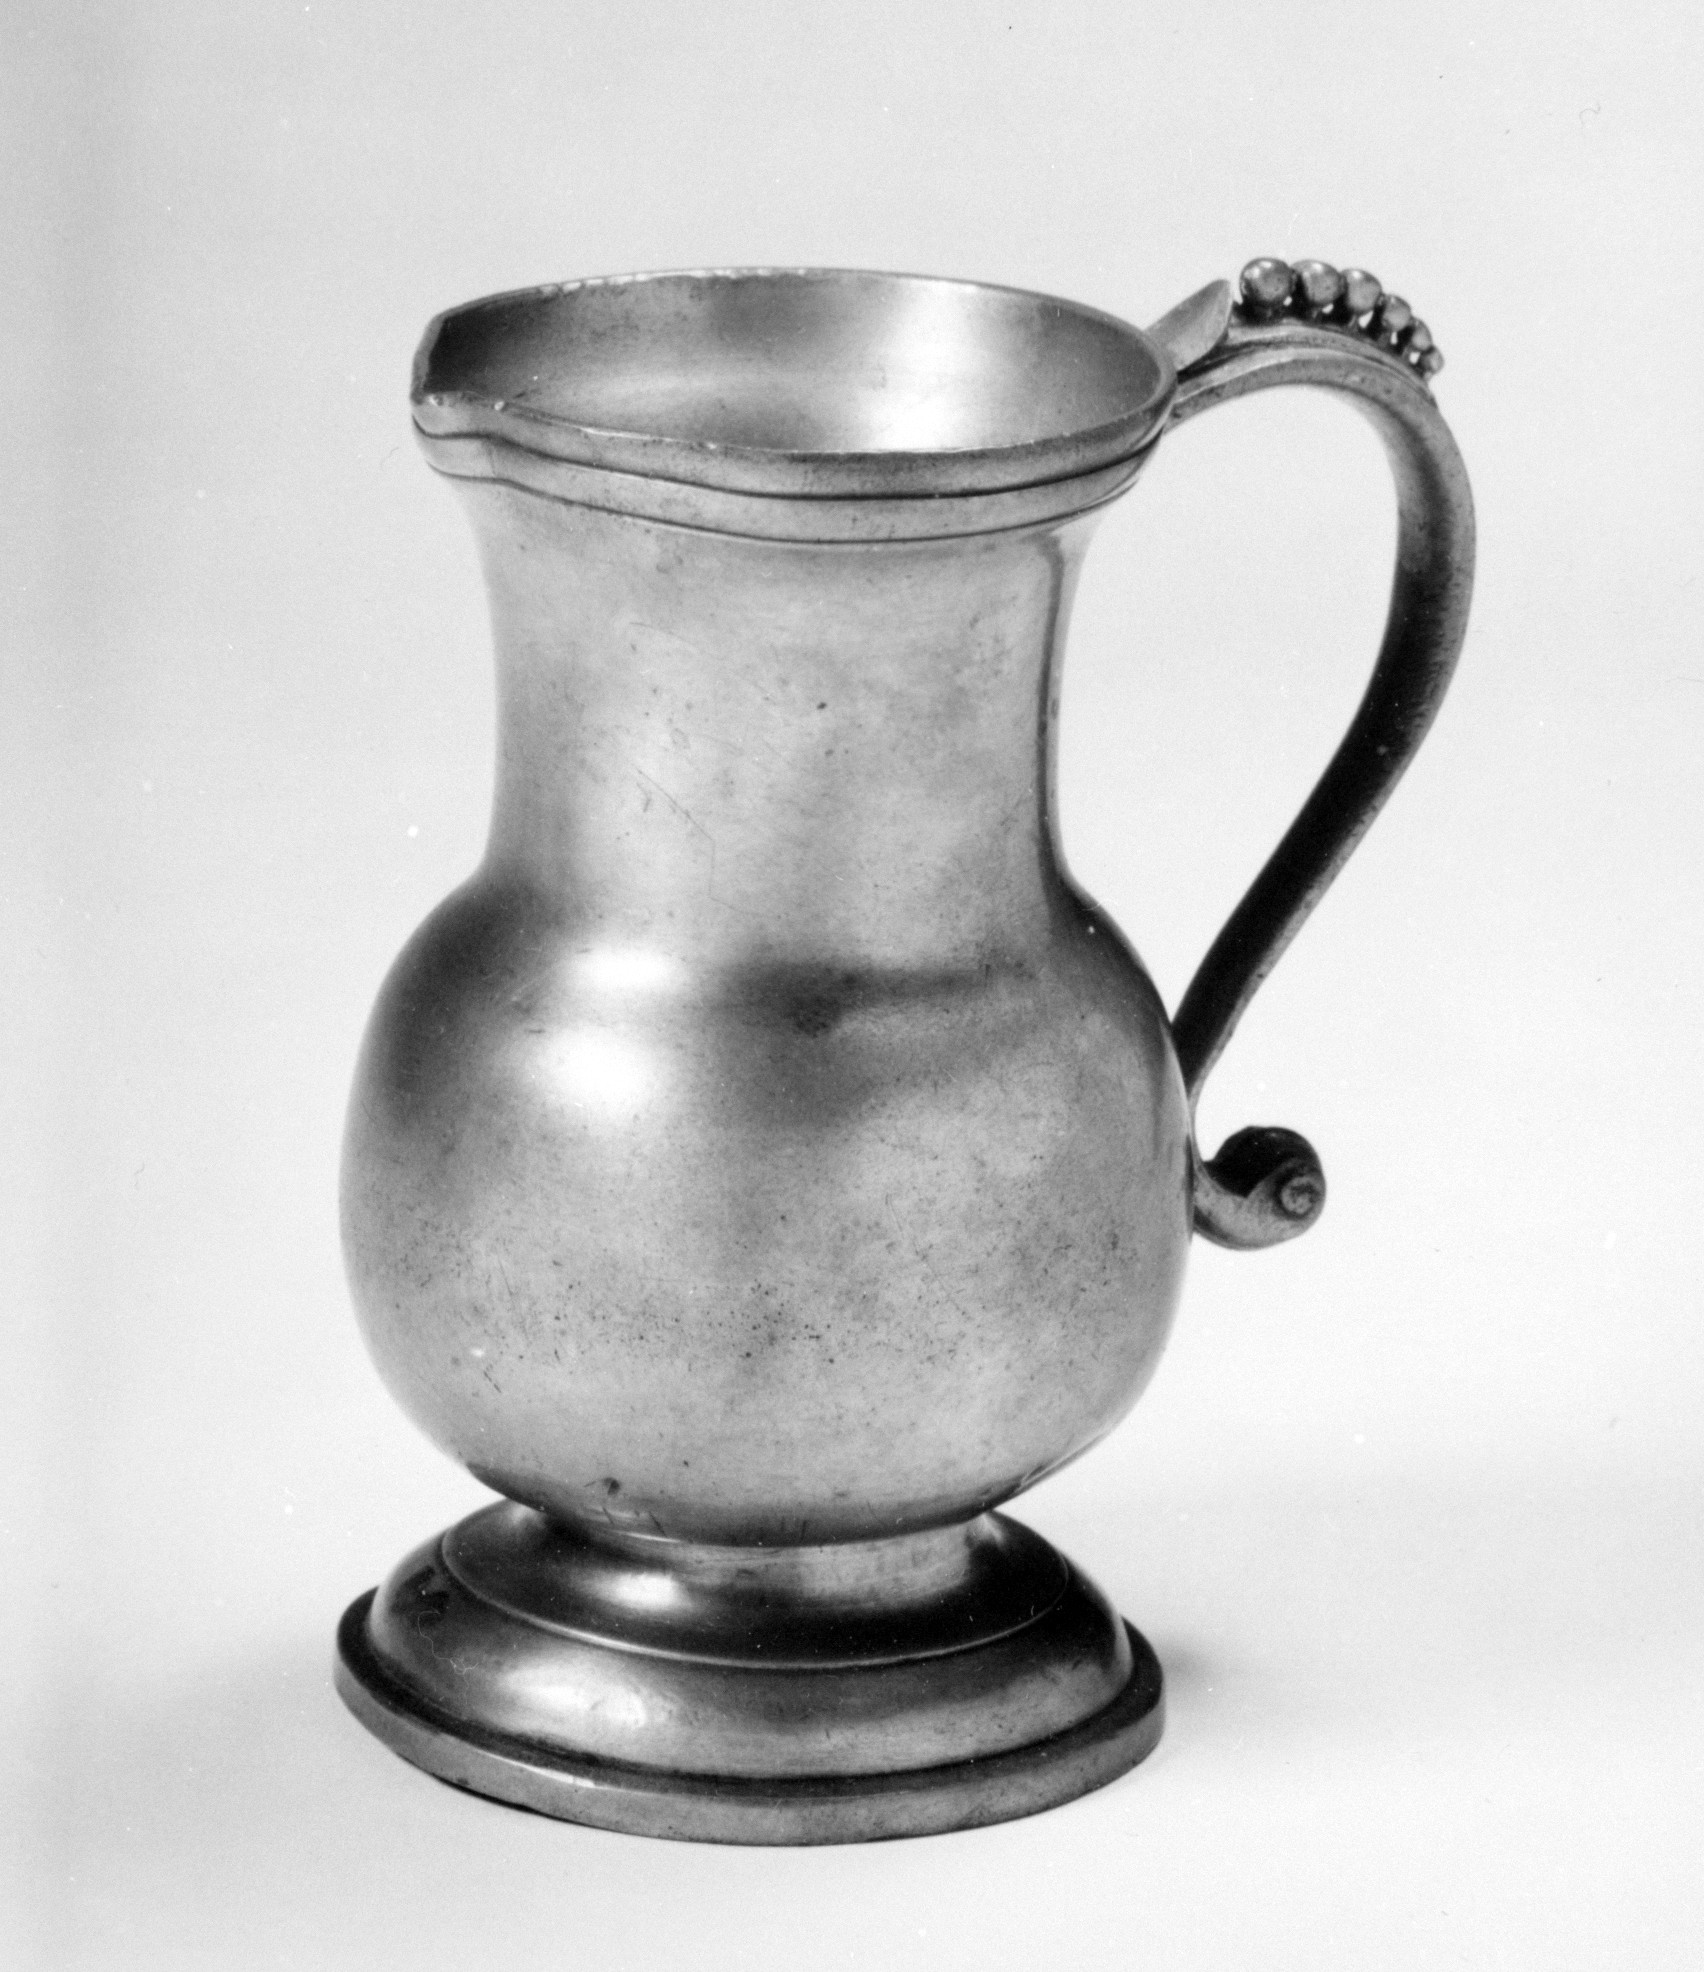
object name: pitcher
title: Pitcher (Pot à Chenille)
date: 1867-1900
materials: pewter